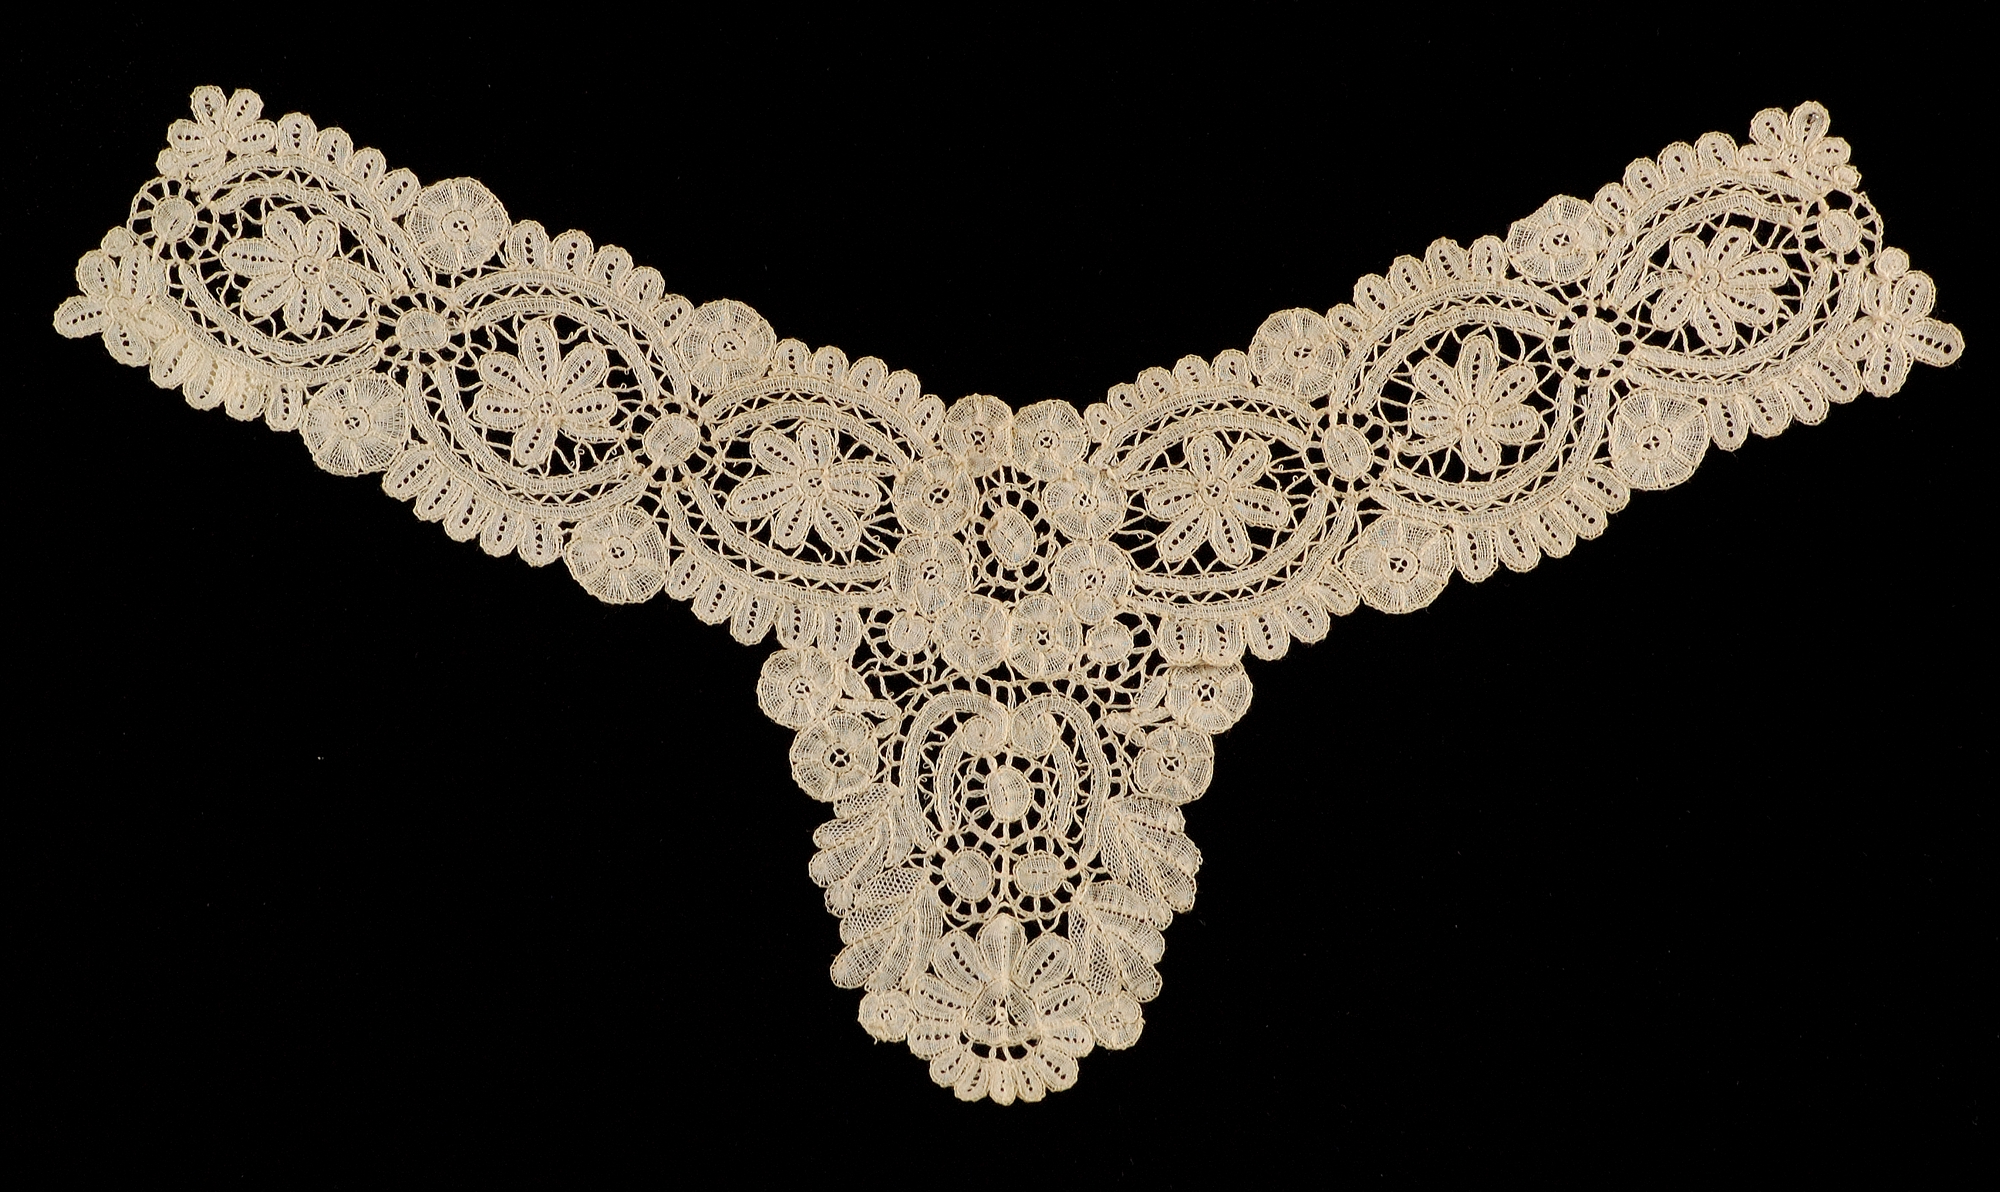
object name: collar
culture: belgian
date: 1890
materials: linen